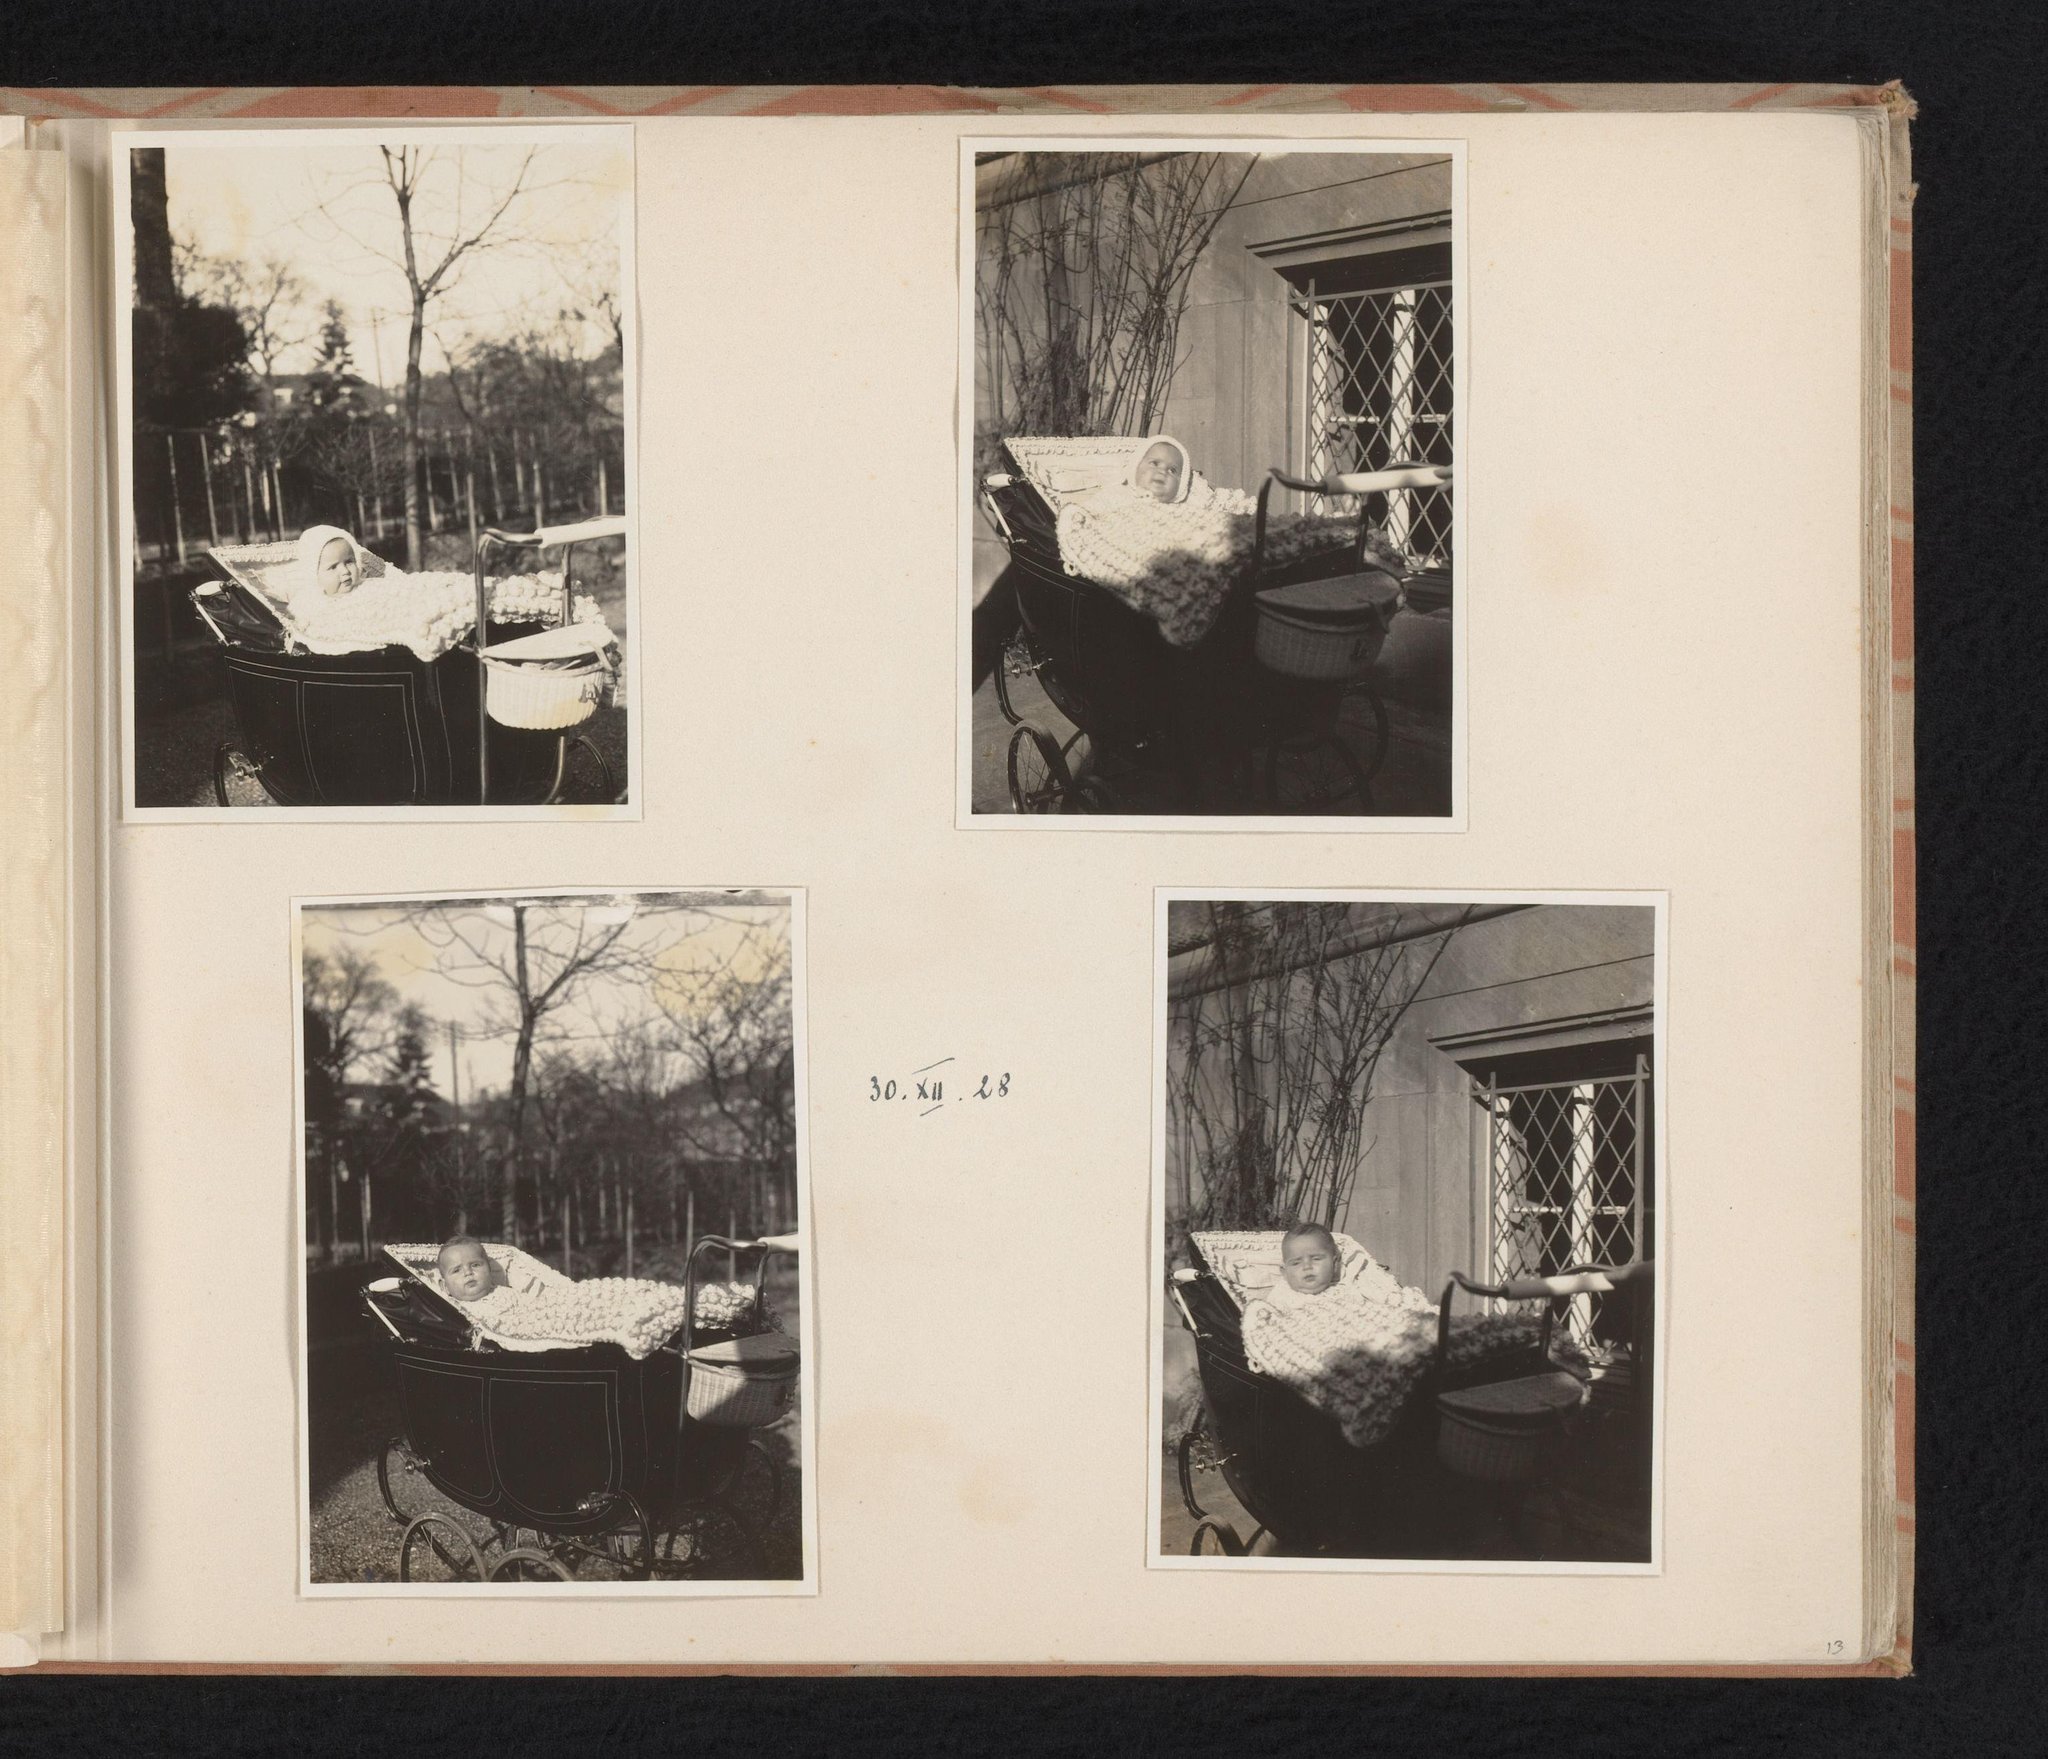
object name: photograph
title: Isabel Wachenheimer in een kinderwagen, 30 december 1928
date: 1928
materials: paper, photographic support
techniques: gelatin silver print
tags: leiden, isabel wachenheimer-elon, baby-carriage, pram, perambulator, family life at home, infant, baby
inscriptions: date: ‘30.12.28’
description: Albumblad met vier foto's met Isabel Wachenheimer. Onderdeel van het fotoalbum met foto's van Isabel Wachenheimer als kind (1928-1931).